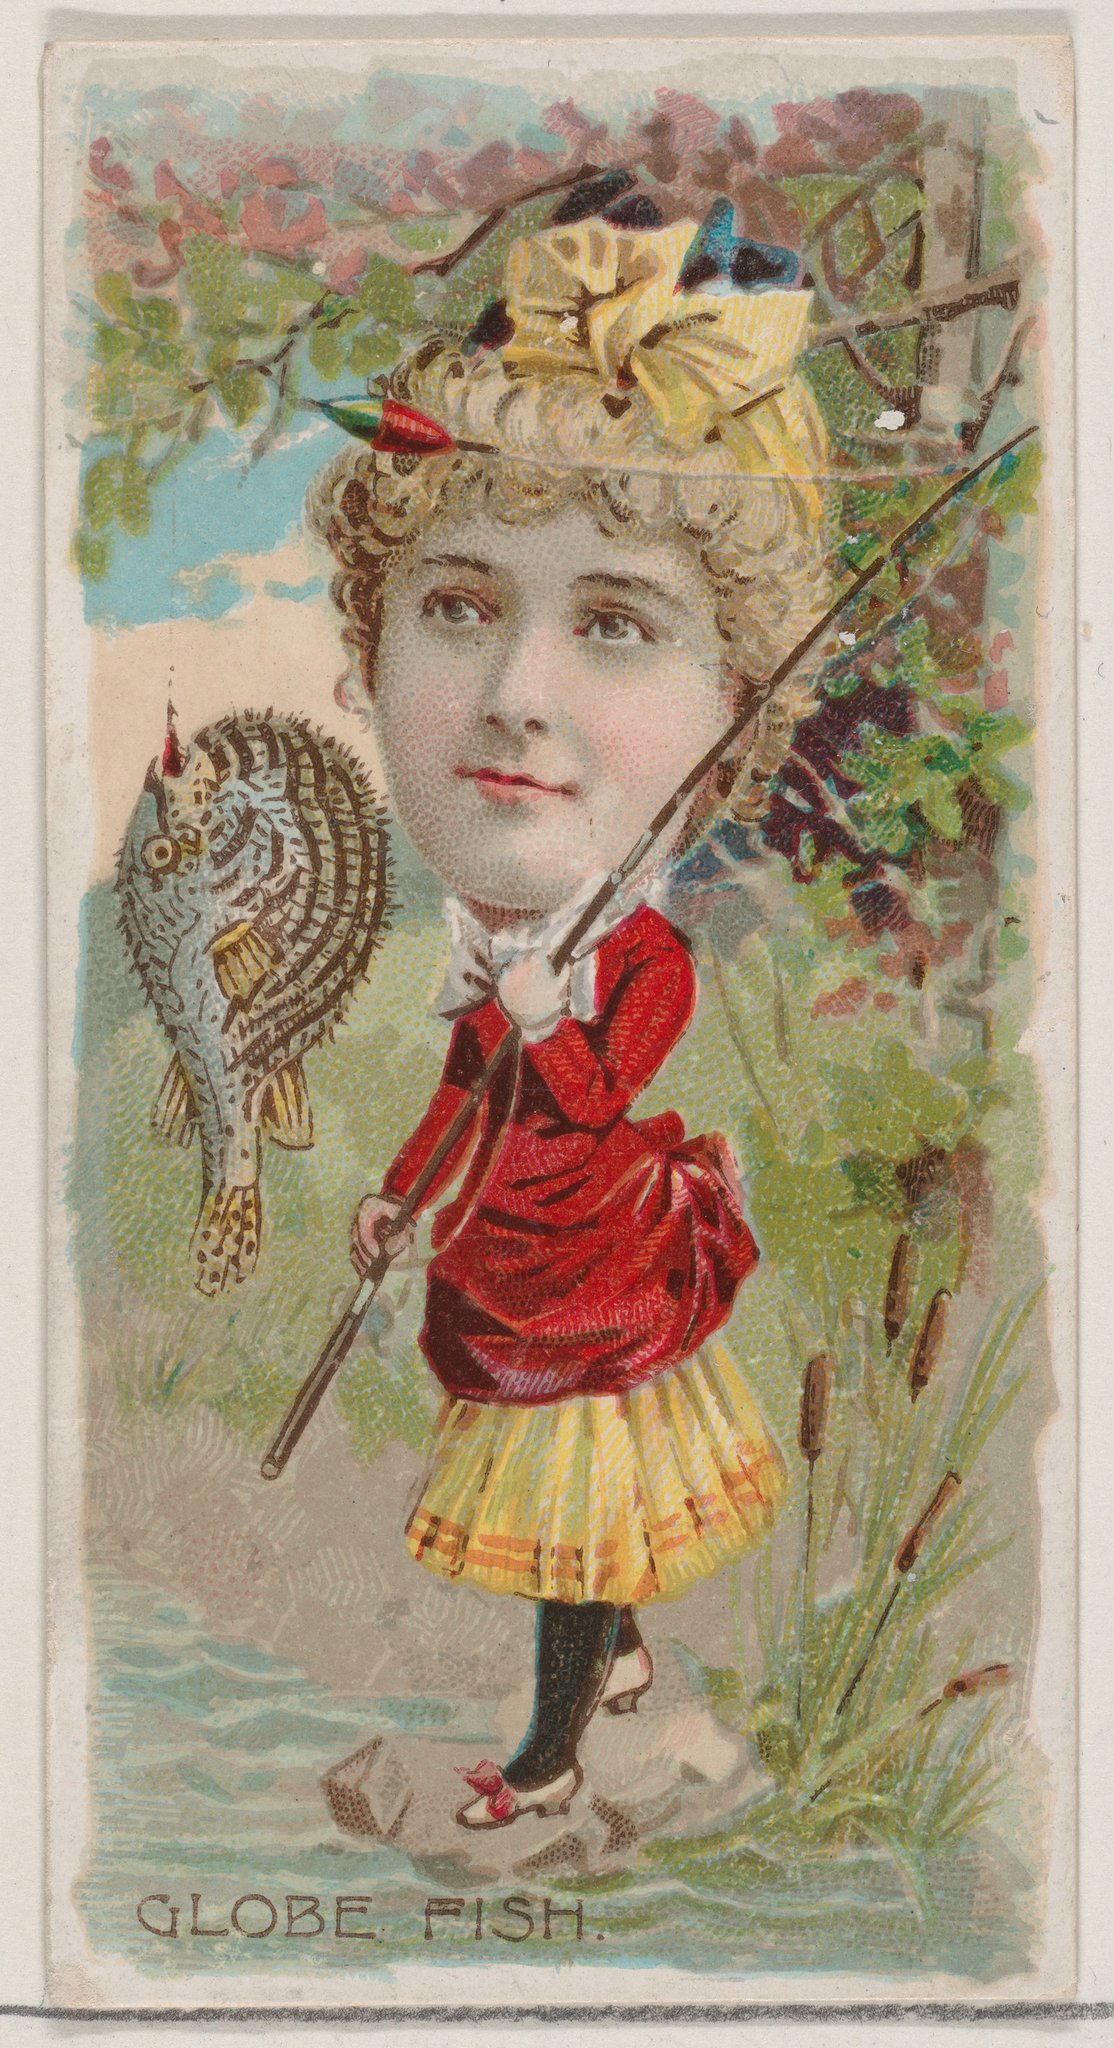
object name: print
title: Globe Fish, from the series Fishers and Fish (N74) for Duke brand cigarettes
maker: knapp & company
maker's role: lithographer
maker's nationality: american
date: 1888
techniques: color lithograph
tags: women,fishing,fish